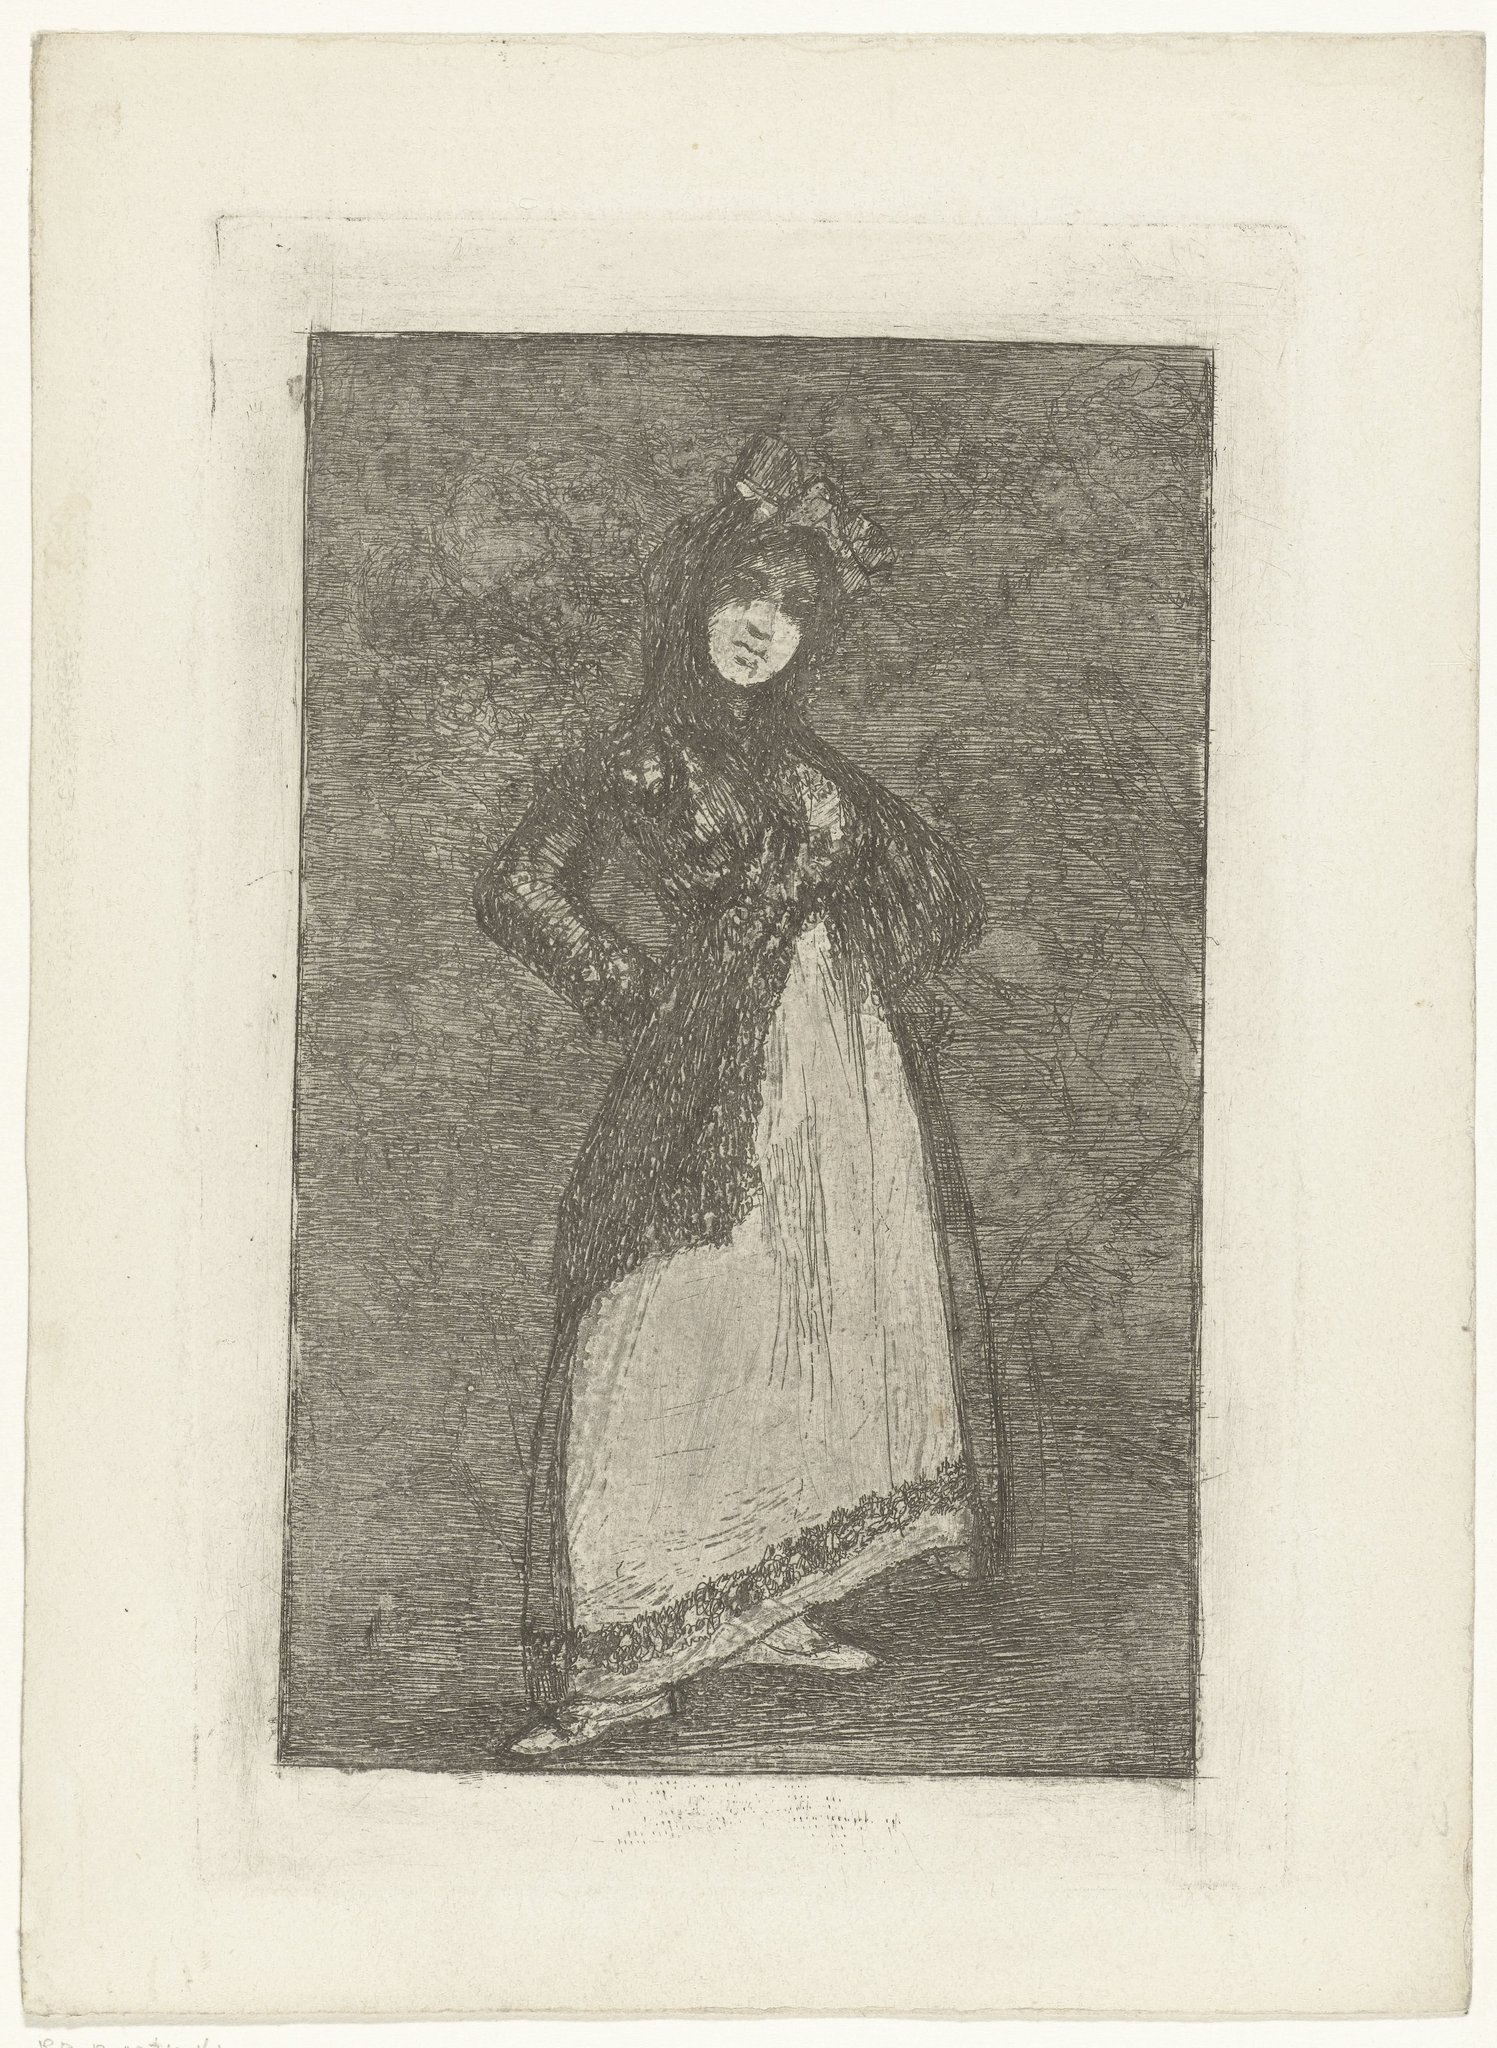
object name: print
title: Maja met de donkere achtergrond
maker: francisco de goya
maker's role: draughtsman, painter, print maker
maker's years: 1746-1828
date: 1824-1828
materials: paper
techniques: aquatint, etching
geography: bordeaux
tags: adolescent, young woman, maiden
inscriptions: collector's mark: ‘ZB’, collector's mark: Lugt 2228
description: Een jonge vrouw, van voren gezien, tegen een donkere achtergrond.